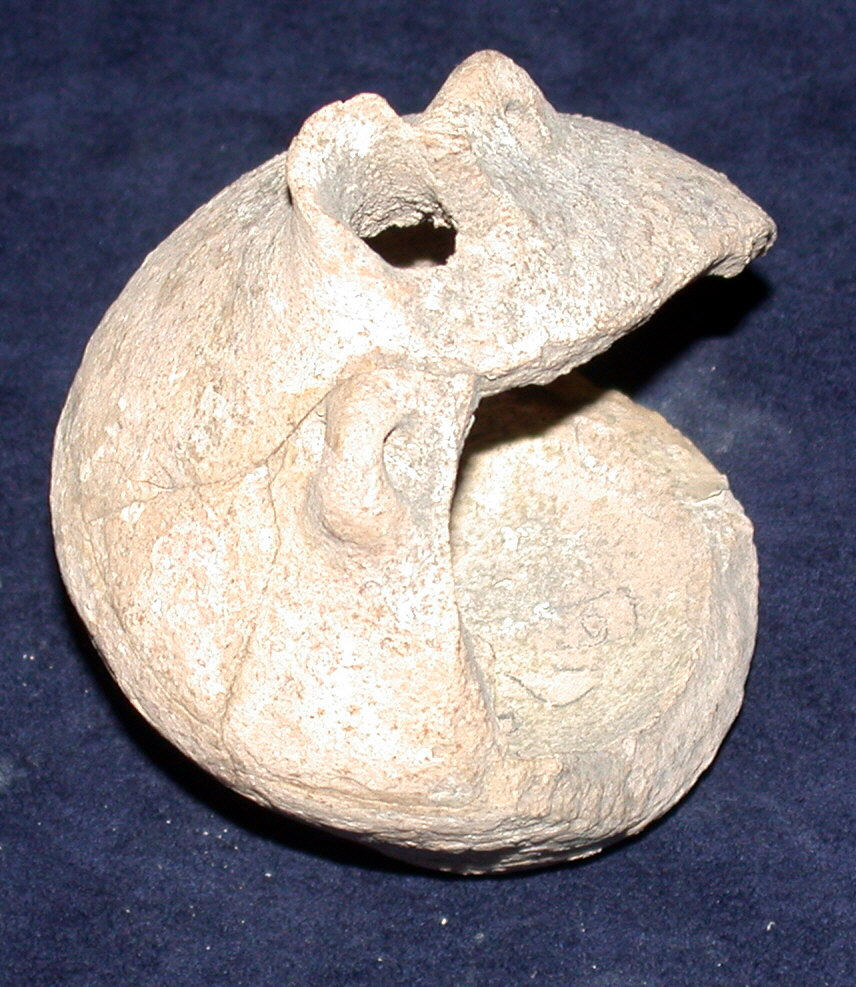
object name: bottle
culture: sasanian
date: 201-700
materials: ceramic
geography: iran